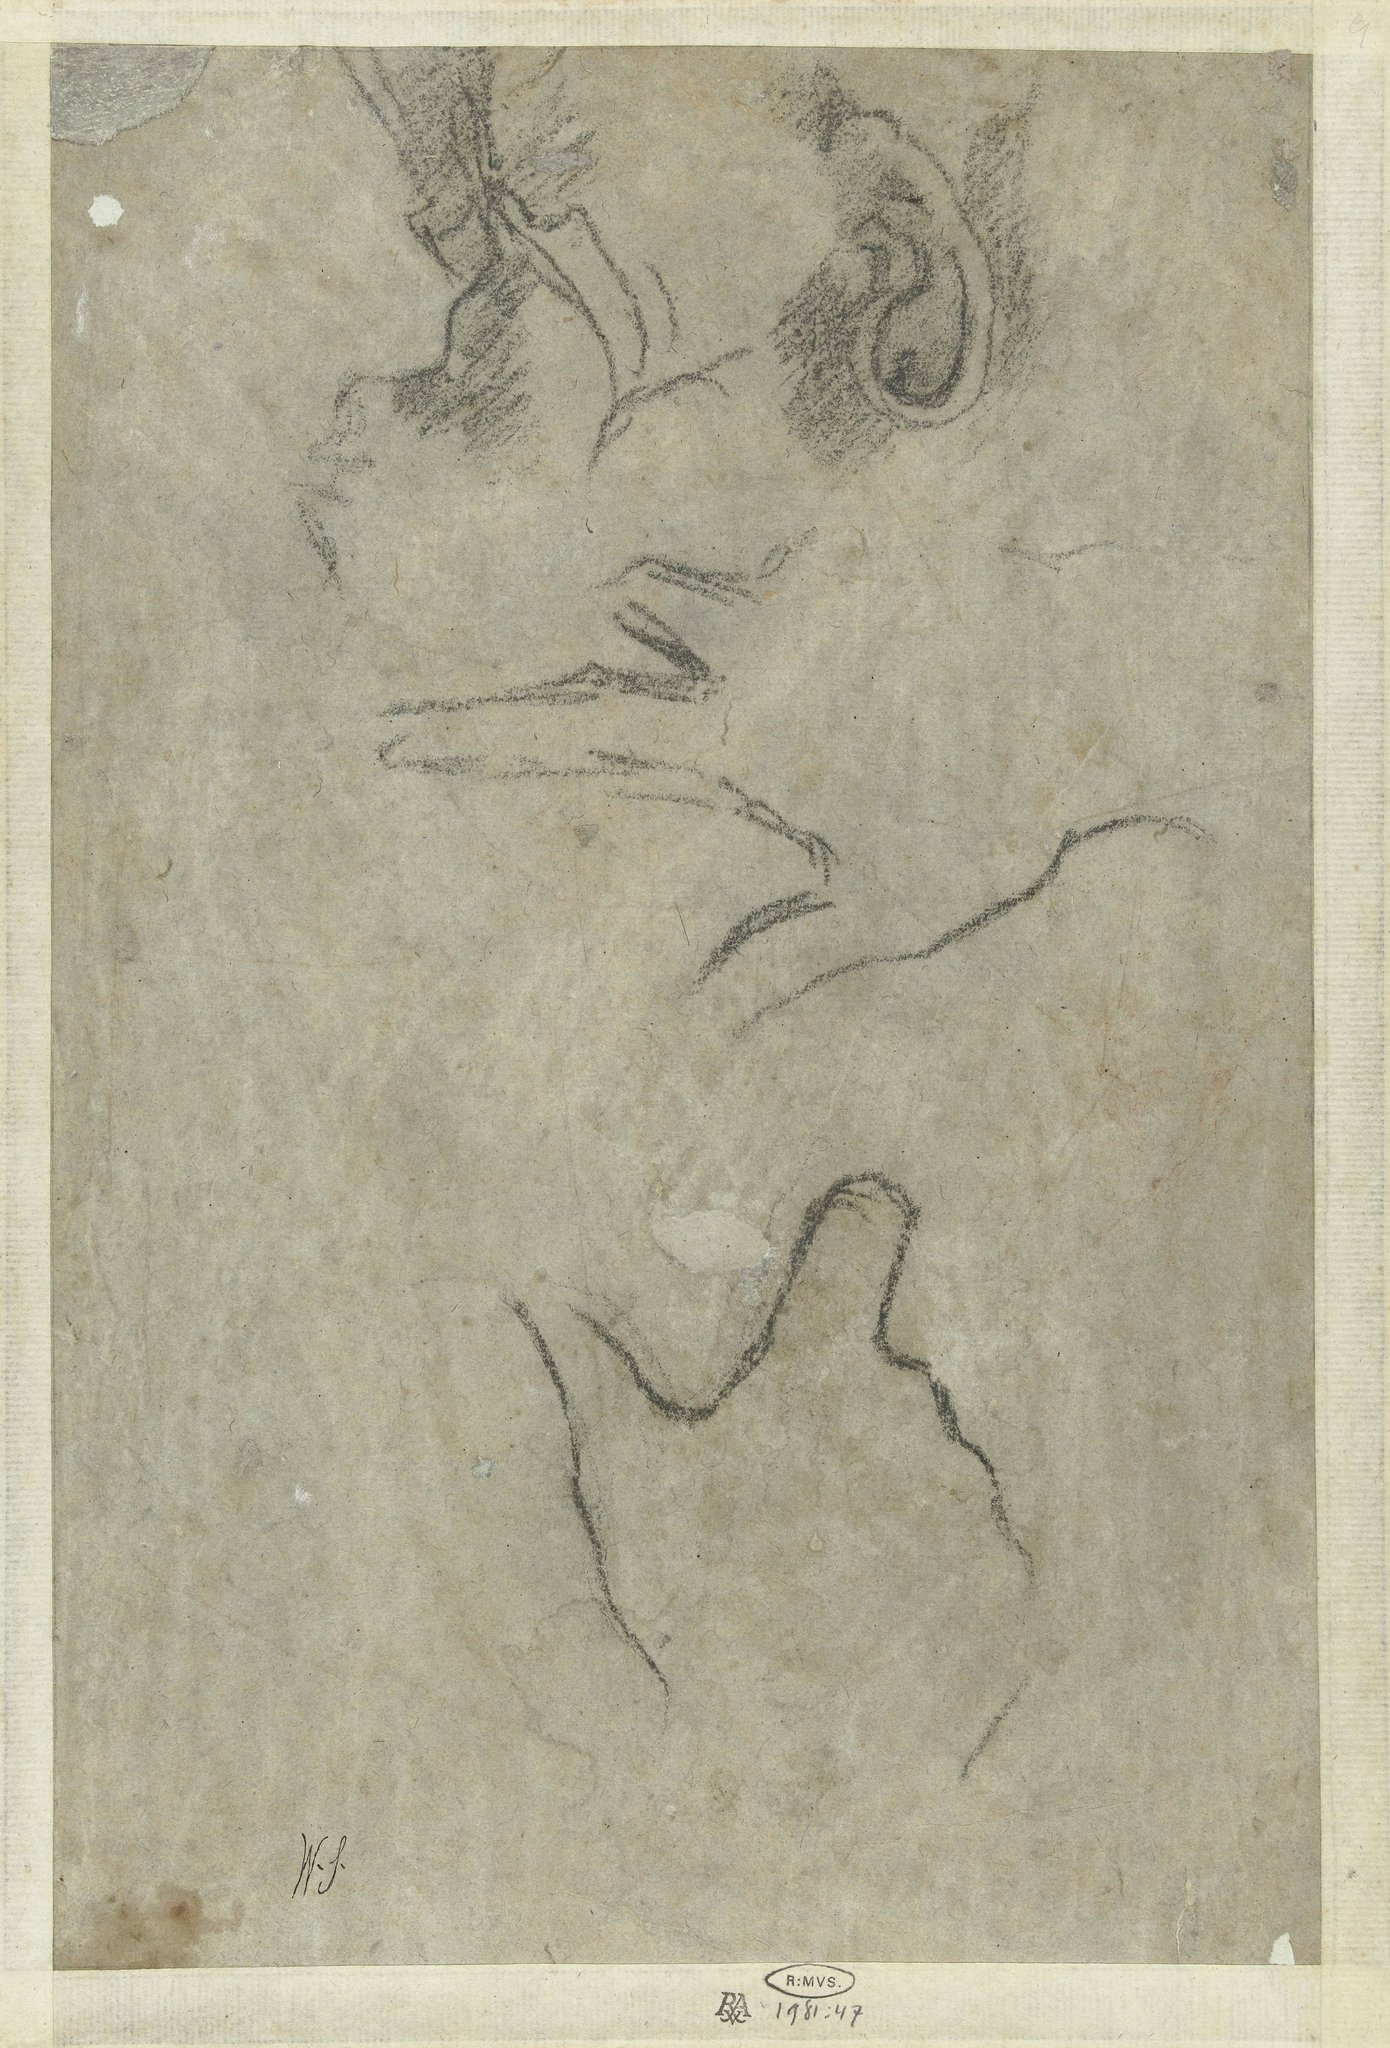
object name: drawing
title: Studies van handen, een hals en een oor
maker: annibale carracci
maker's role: draughtsman, print maker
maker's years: 1560-1609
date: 1595-1609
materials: chalk, paper